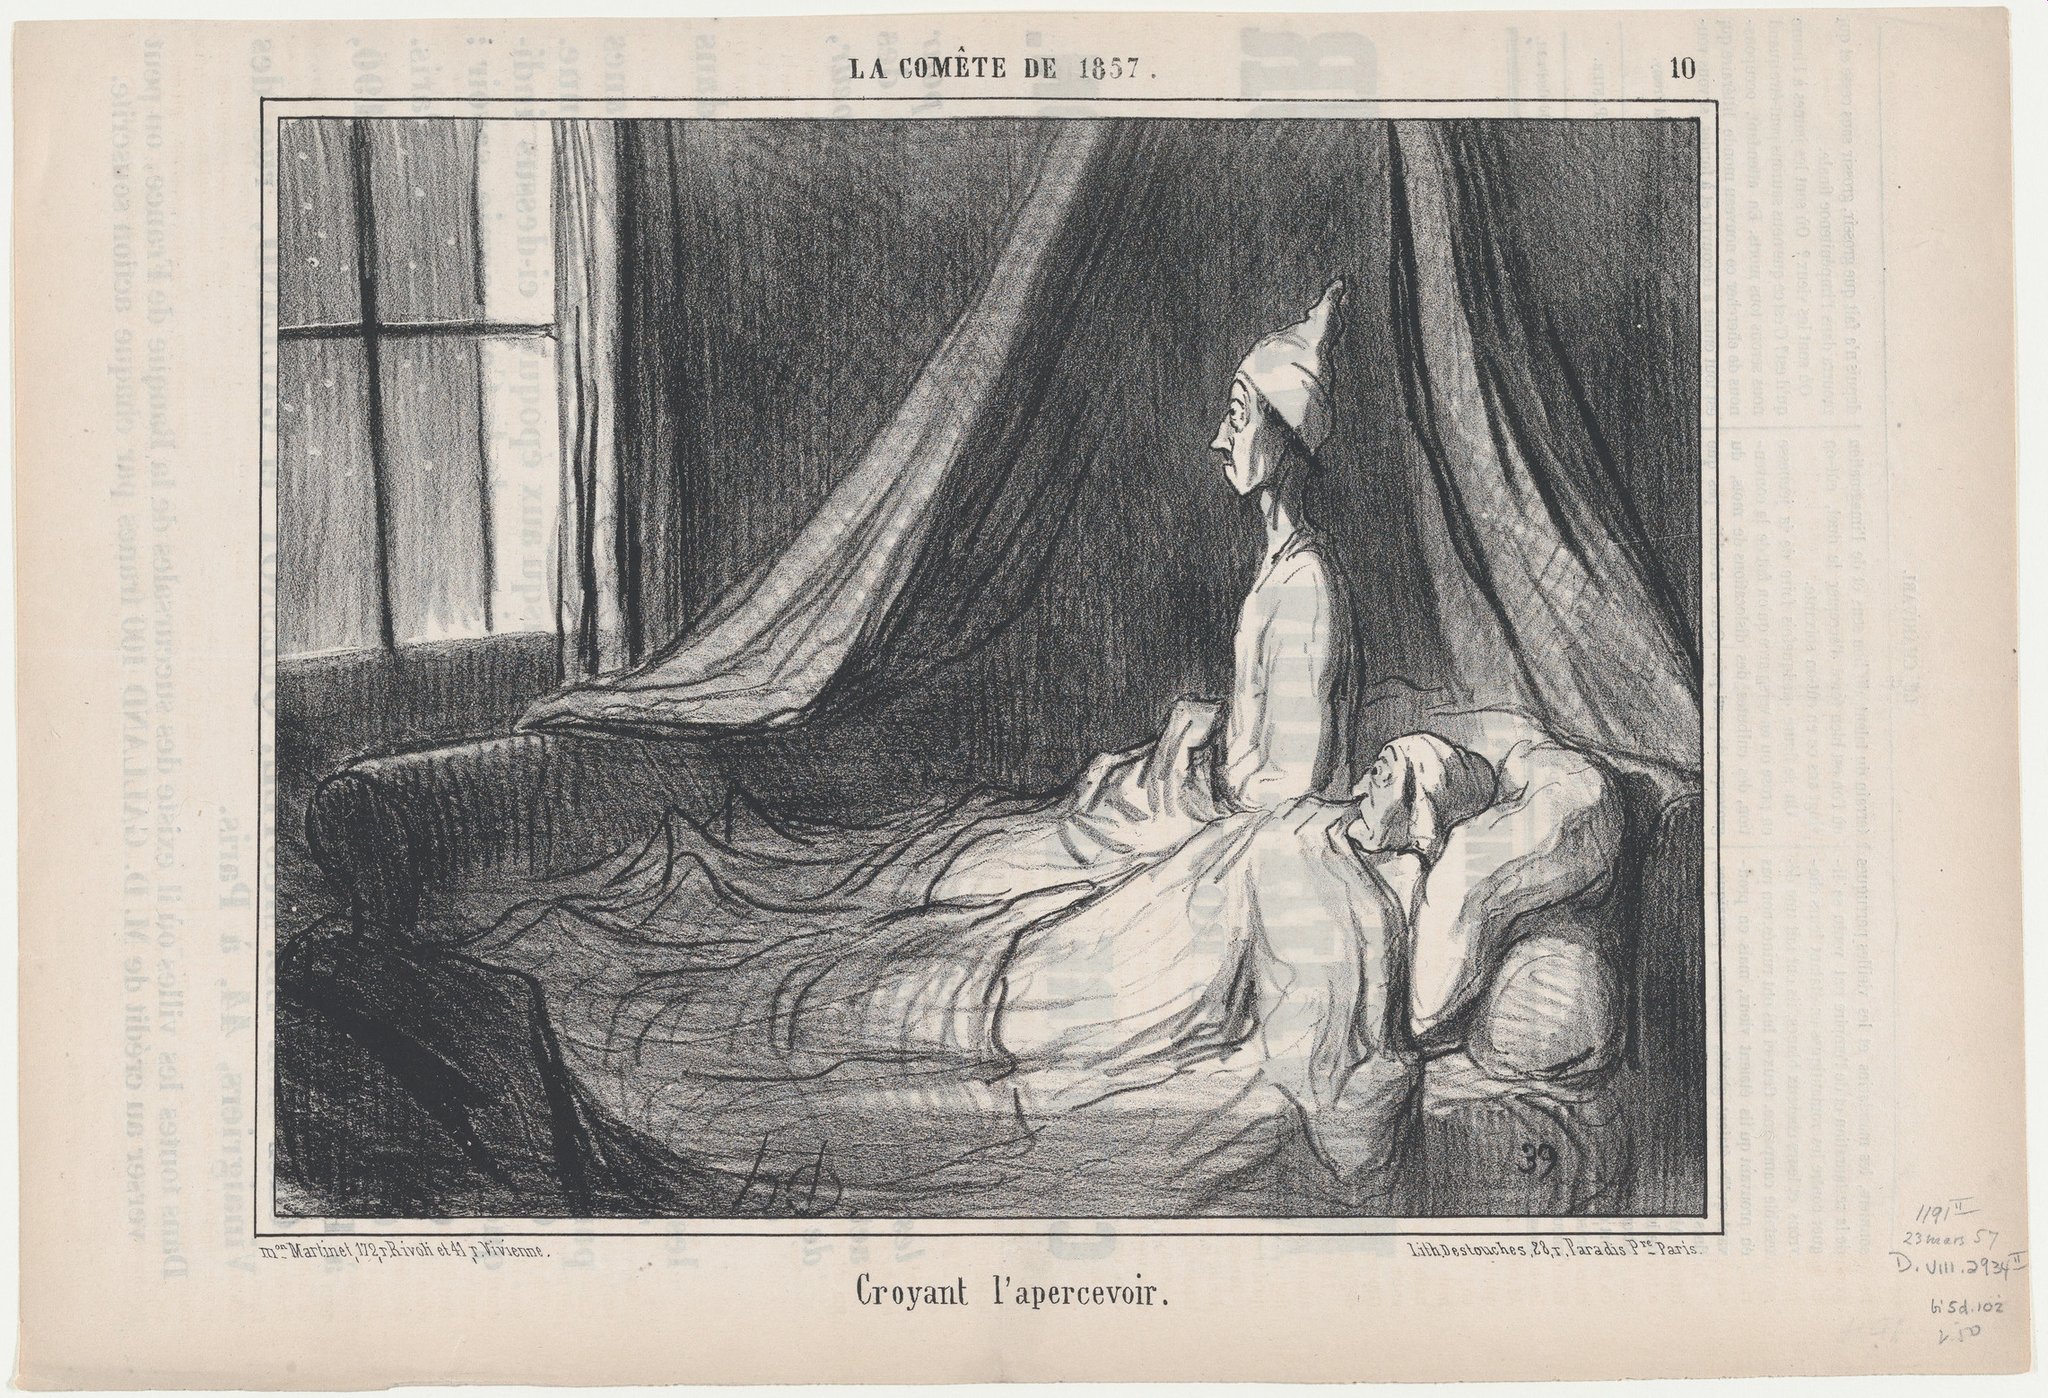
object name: print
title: Croyant l'apercevoir, from 'Croquis Parisiens', published in "Le Charivari"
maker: honoré daumier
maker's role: artist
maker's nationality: french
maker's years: 1808-1879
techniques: lithograph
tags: men,women,beds